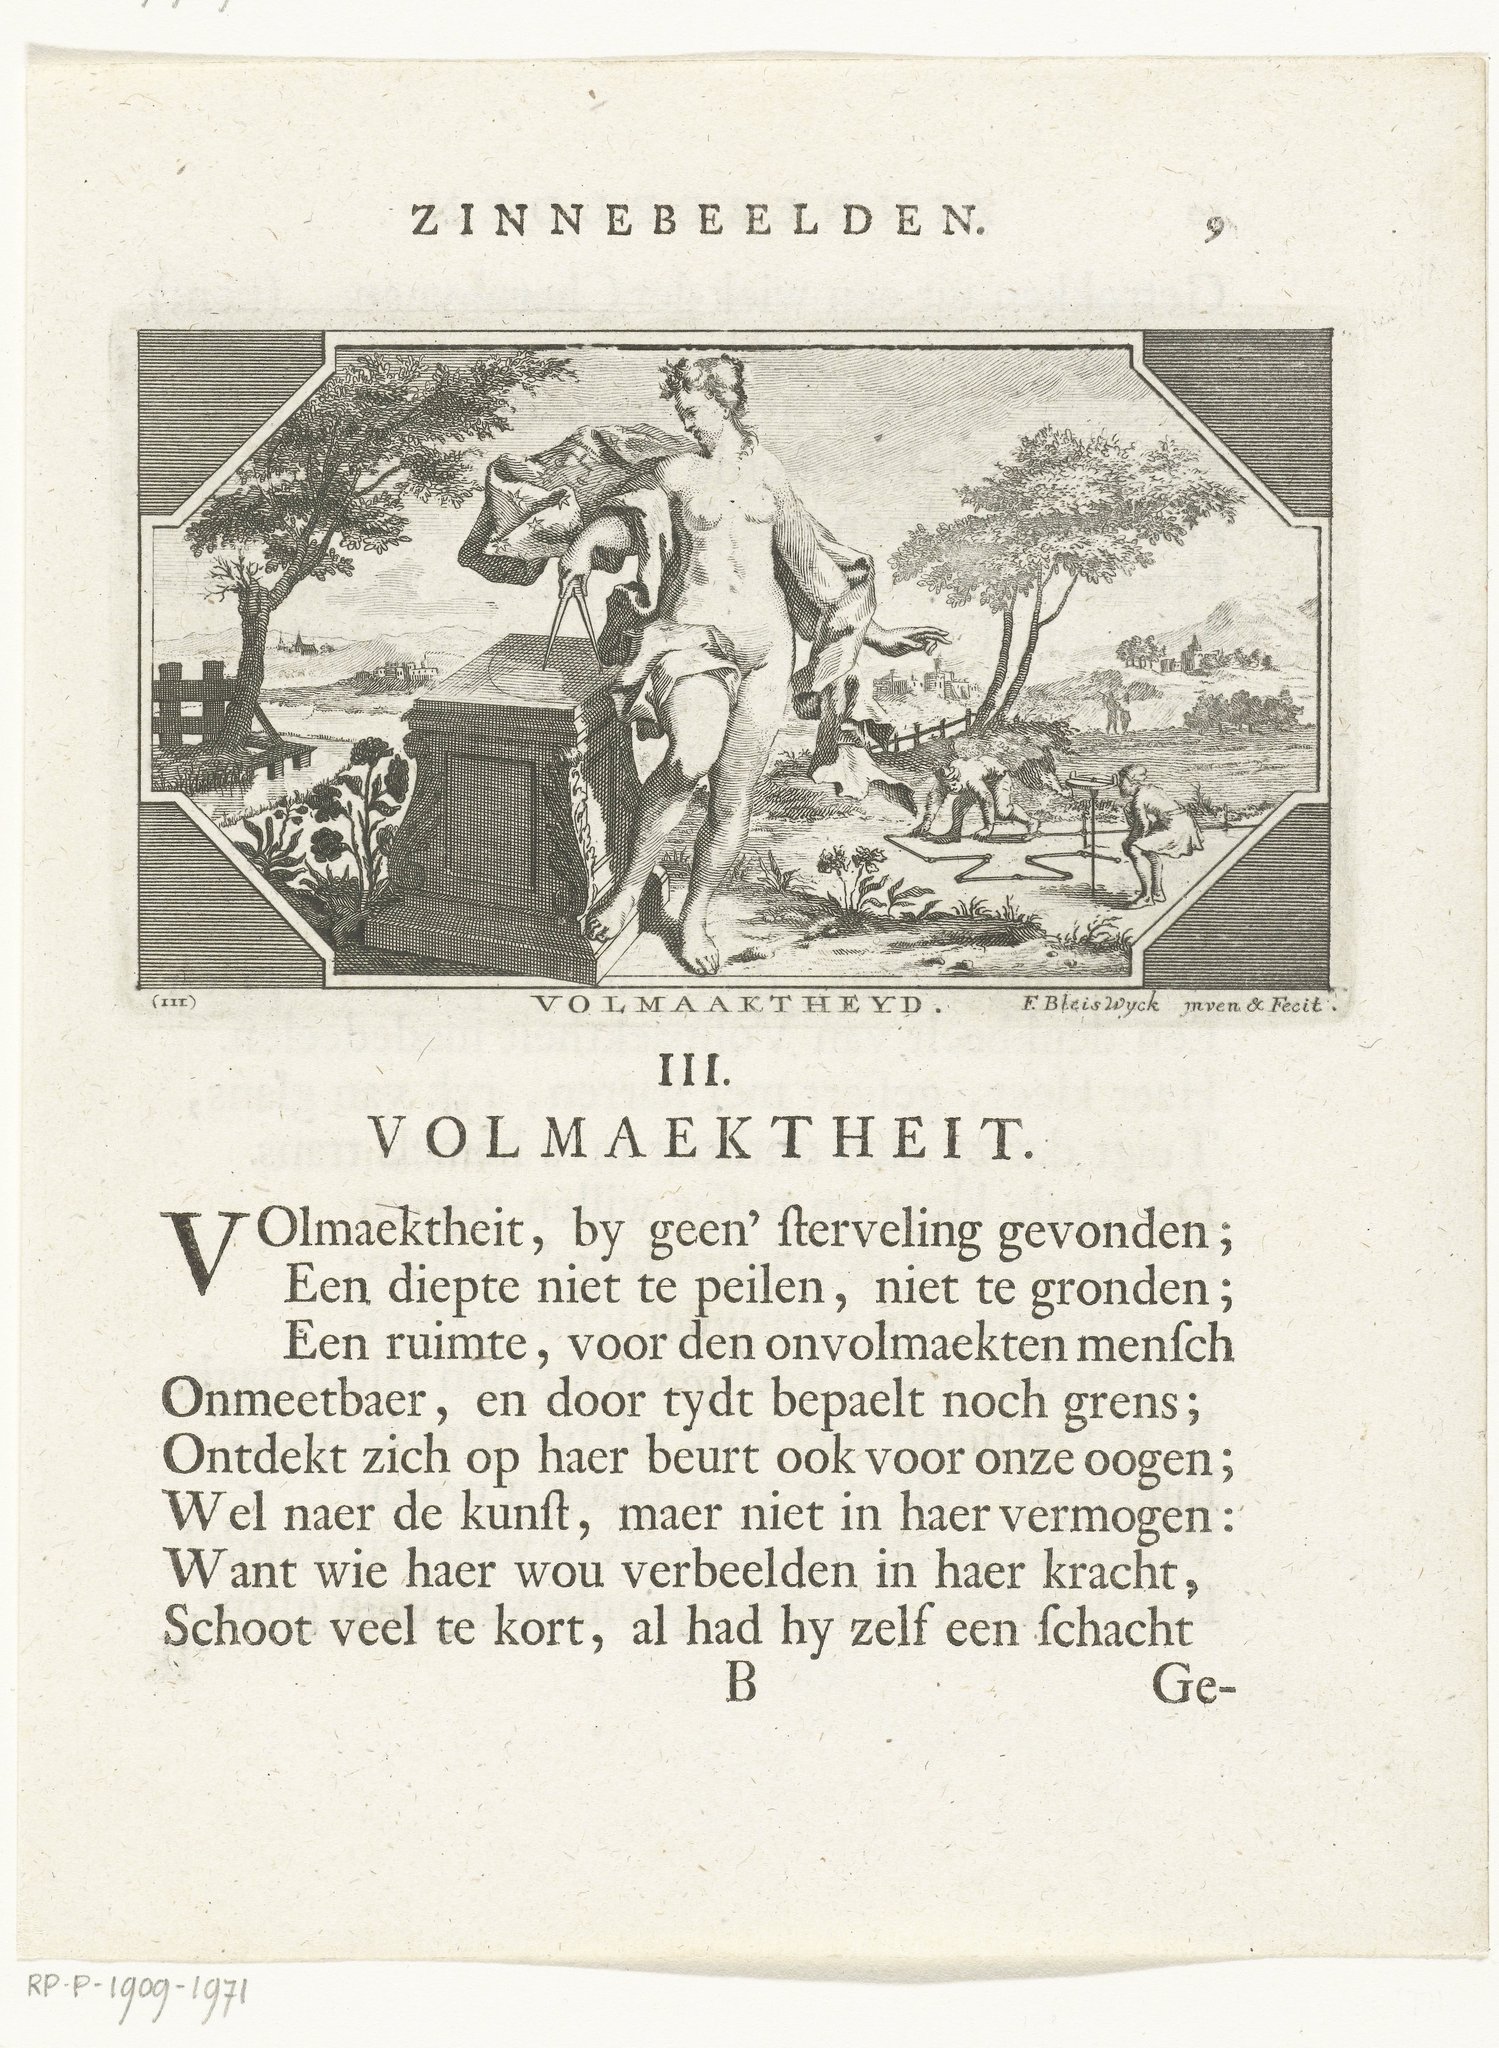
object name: book illustration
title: Embleem met allegorie op volmaaktheid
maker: françois van bleyswijck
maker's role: draughtsman, print maker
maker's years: 1671-1746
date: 1681-1737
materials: paper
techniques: etching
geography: leiden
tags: compasses, abstract ideas and concepts (+ emblematical representation of concept), perfection, completeness; 'perfettione', 'operatione perfetta' (ripa)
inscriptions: collector's mark: Lugt 2228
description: Embleem met allegorie op volmaaktheid verbeeld met halfnaakte vrouw die op sokkel een cirkel tekent met een passer. In het landschap werken twee mannen met meetinstrumenten.